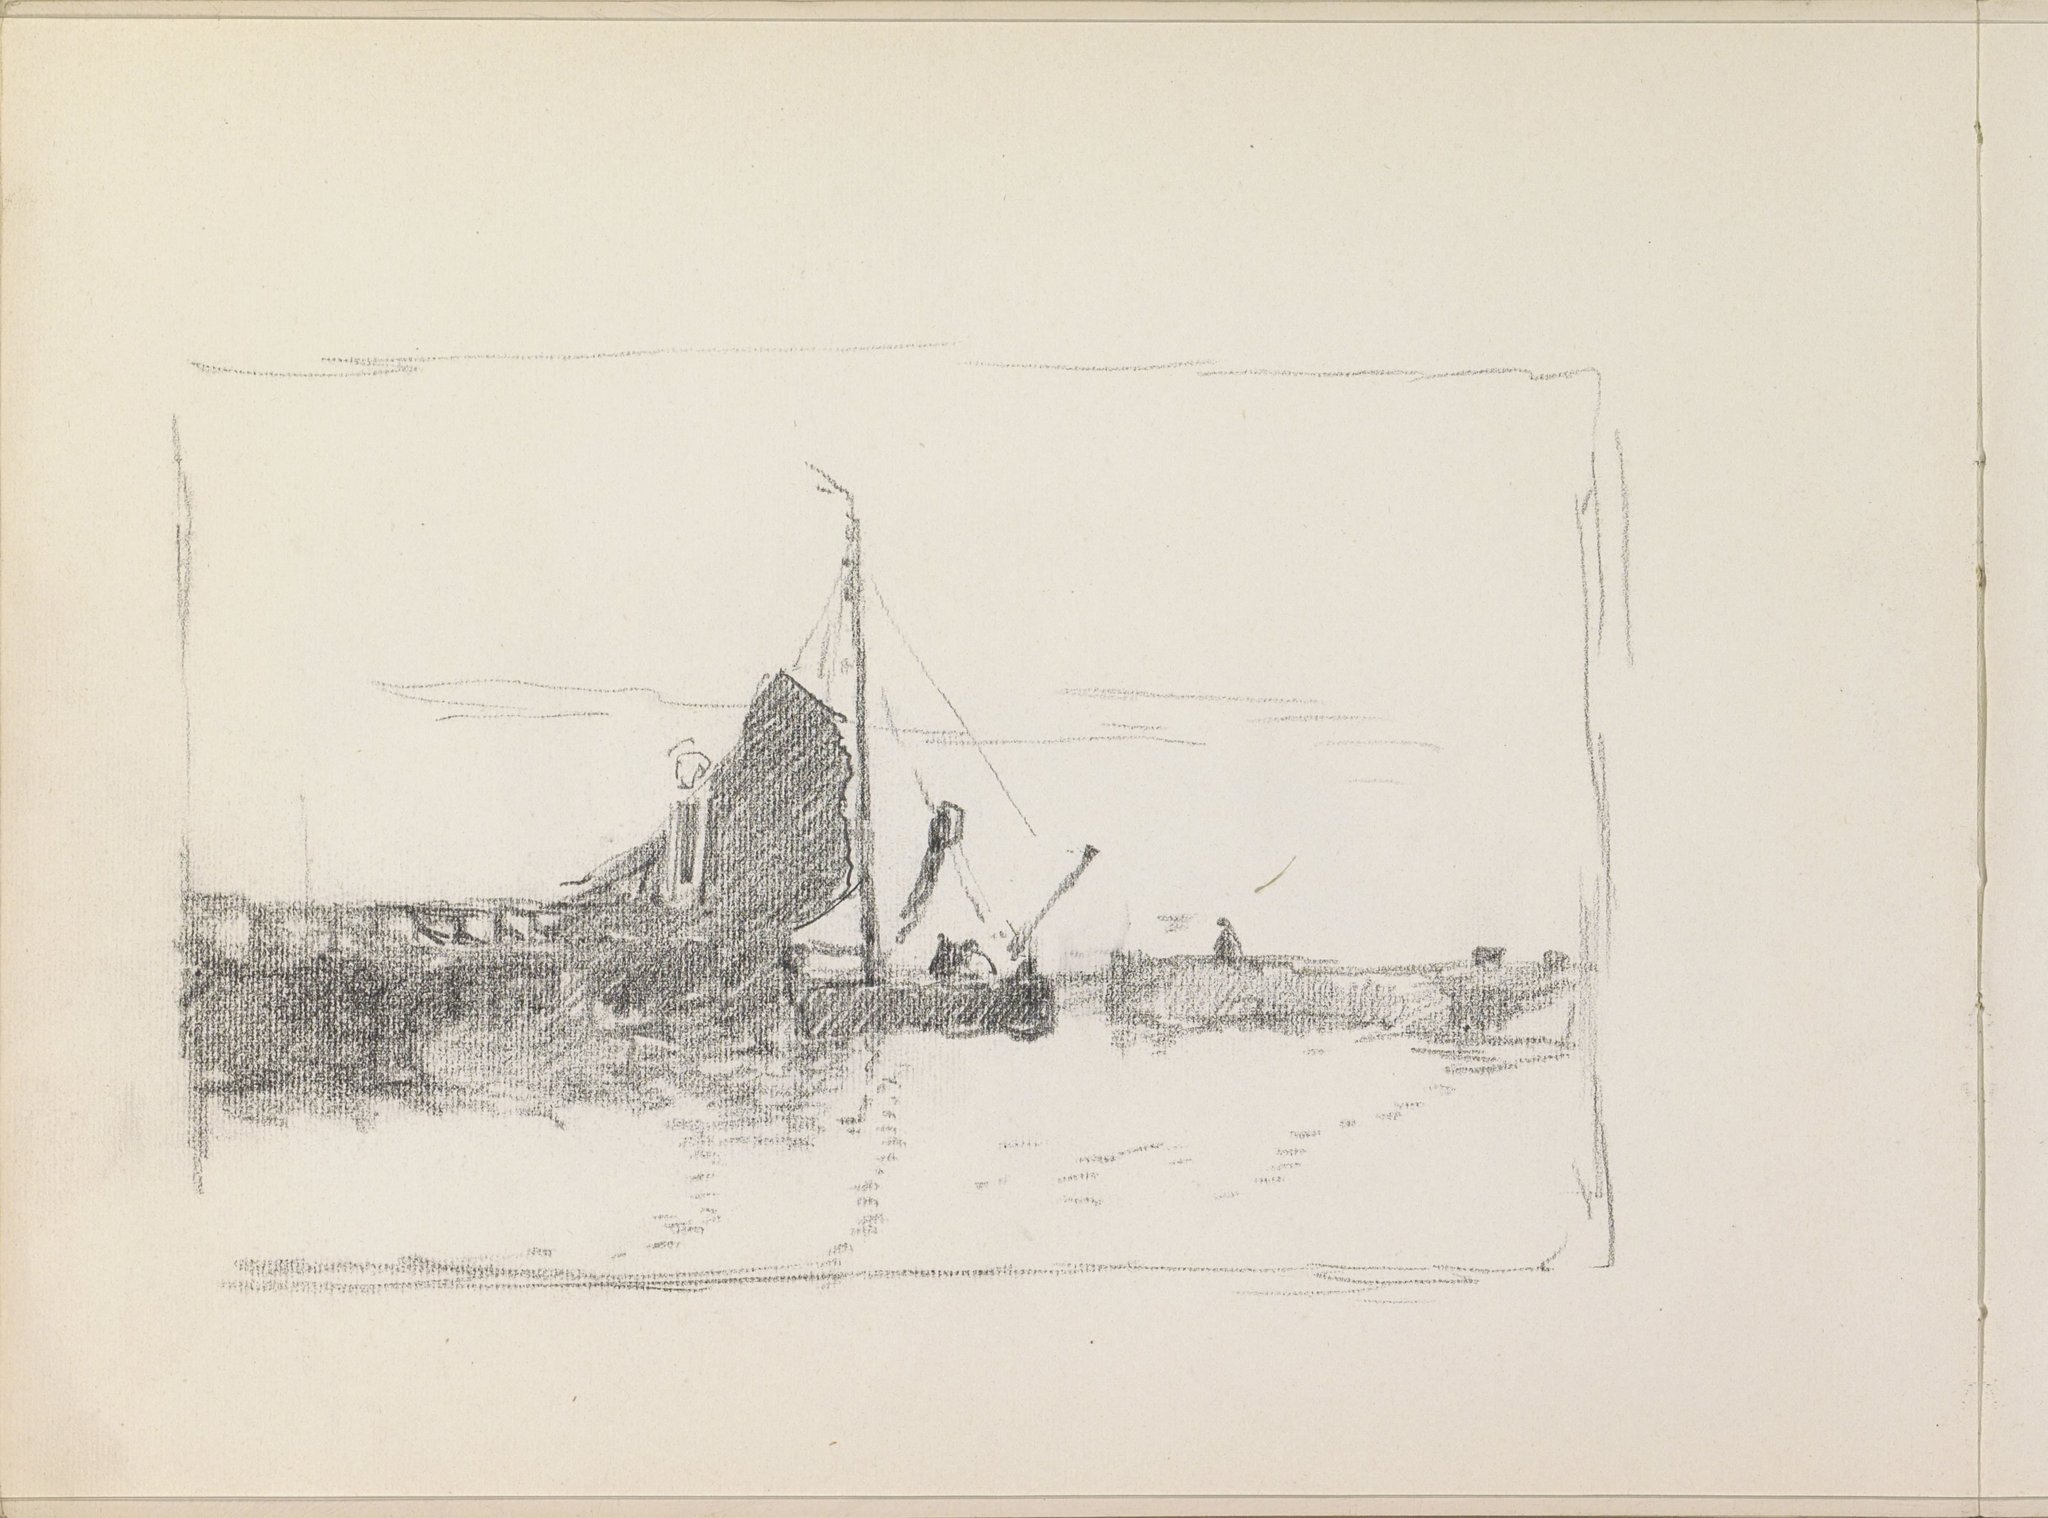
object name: sketchbook leaf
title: Boten bij een aanlegsteiger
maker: cornelis vreedenburgh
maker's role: draughtsman, print maker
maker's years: 1880-1946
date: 1890-1946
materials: chalk, paper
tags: sailing-ship, sailing-boat, pier, quay, wharf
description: Pagina 20 verso uit een schetsboek met 22 bladen.